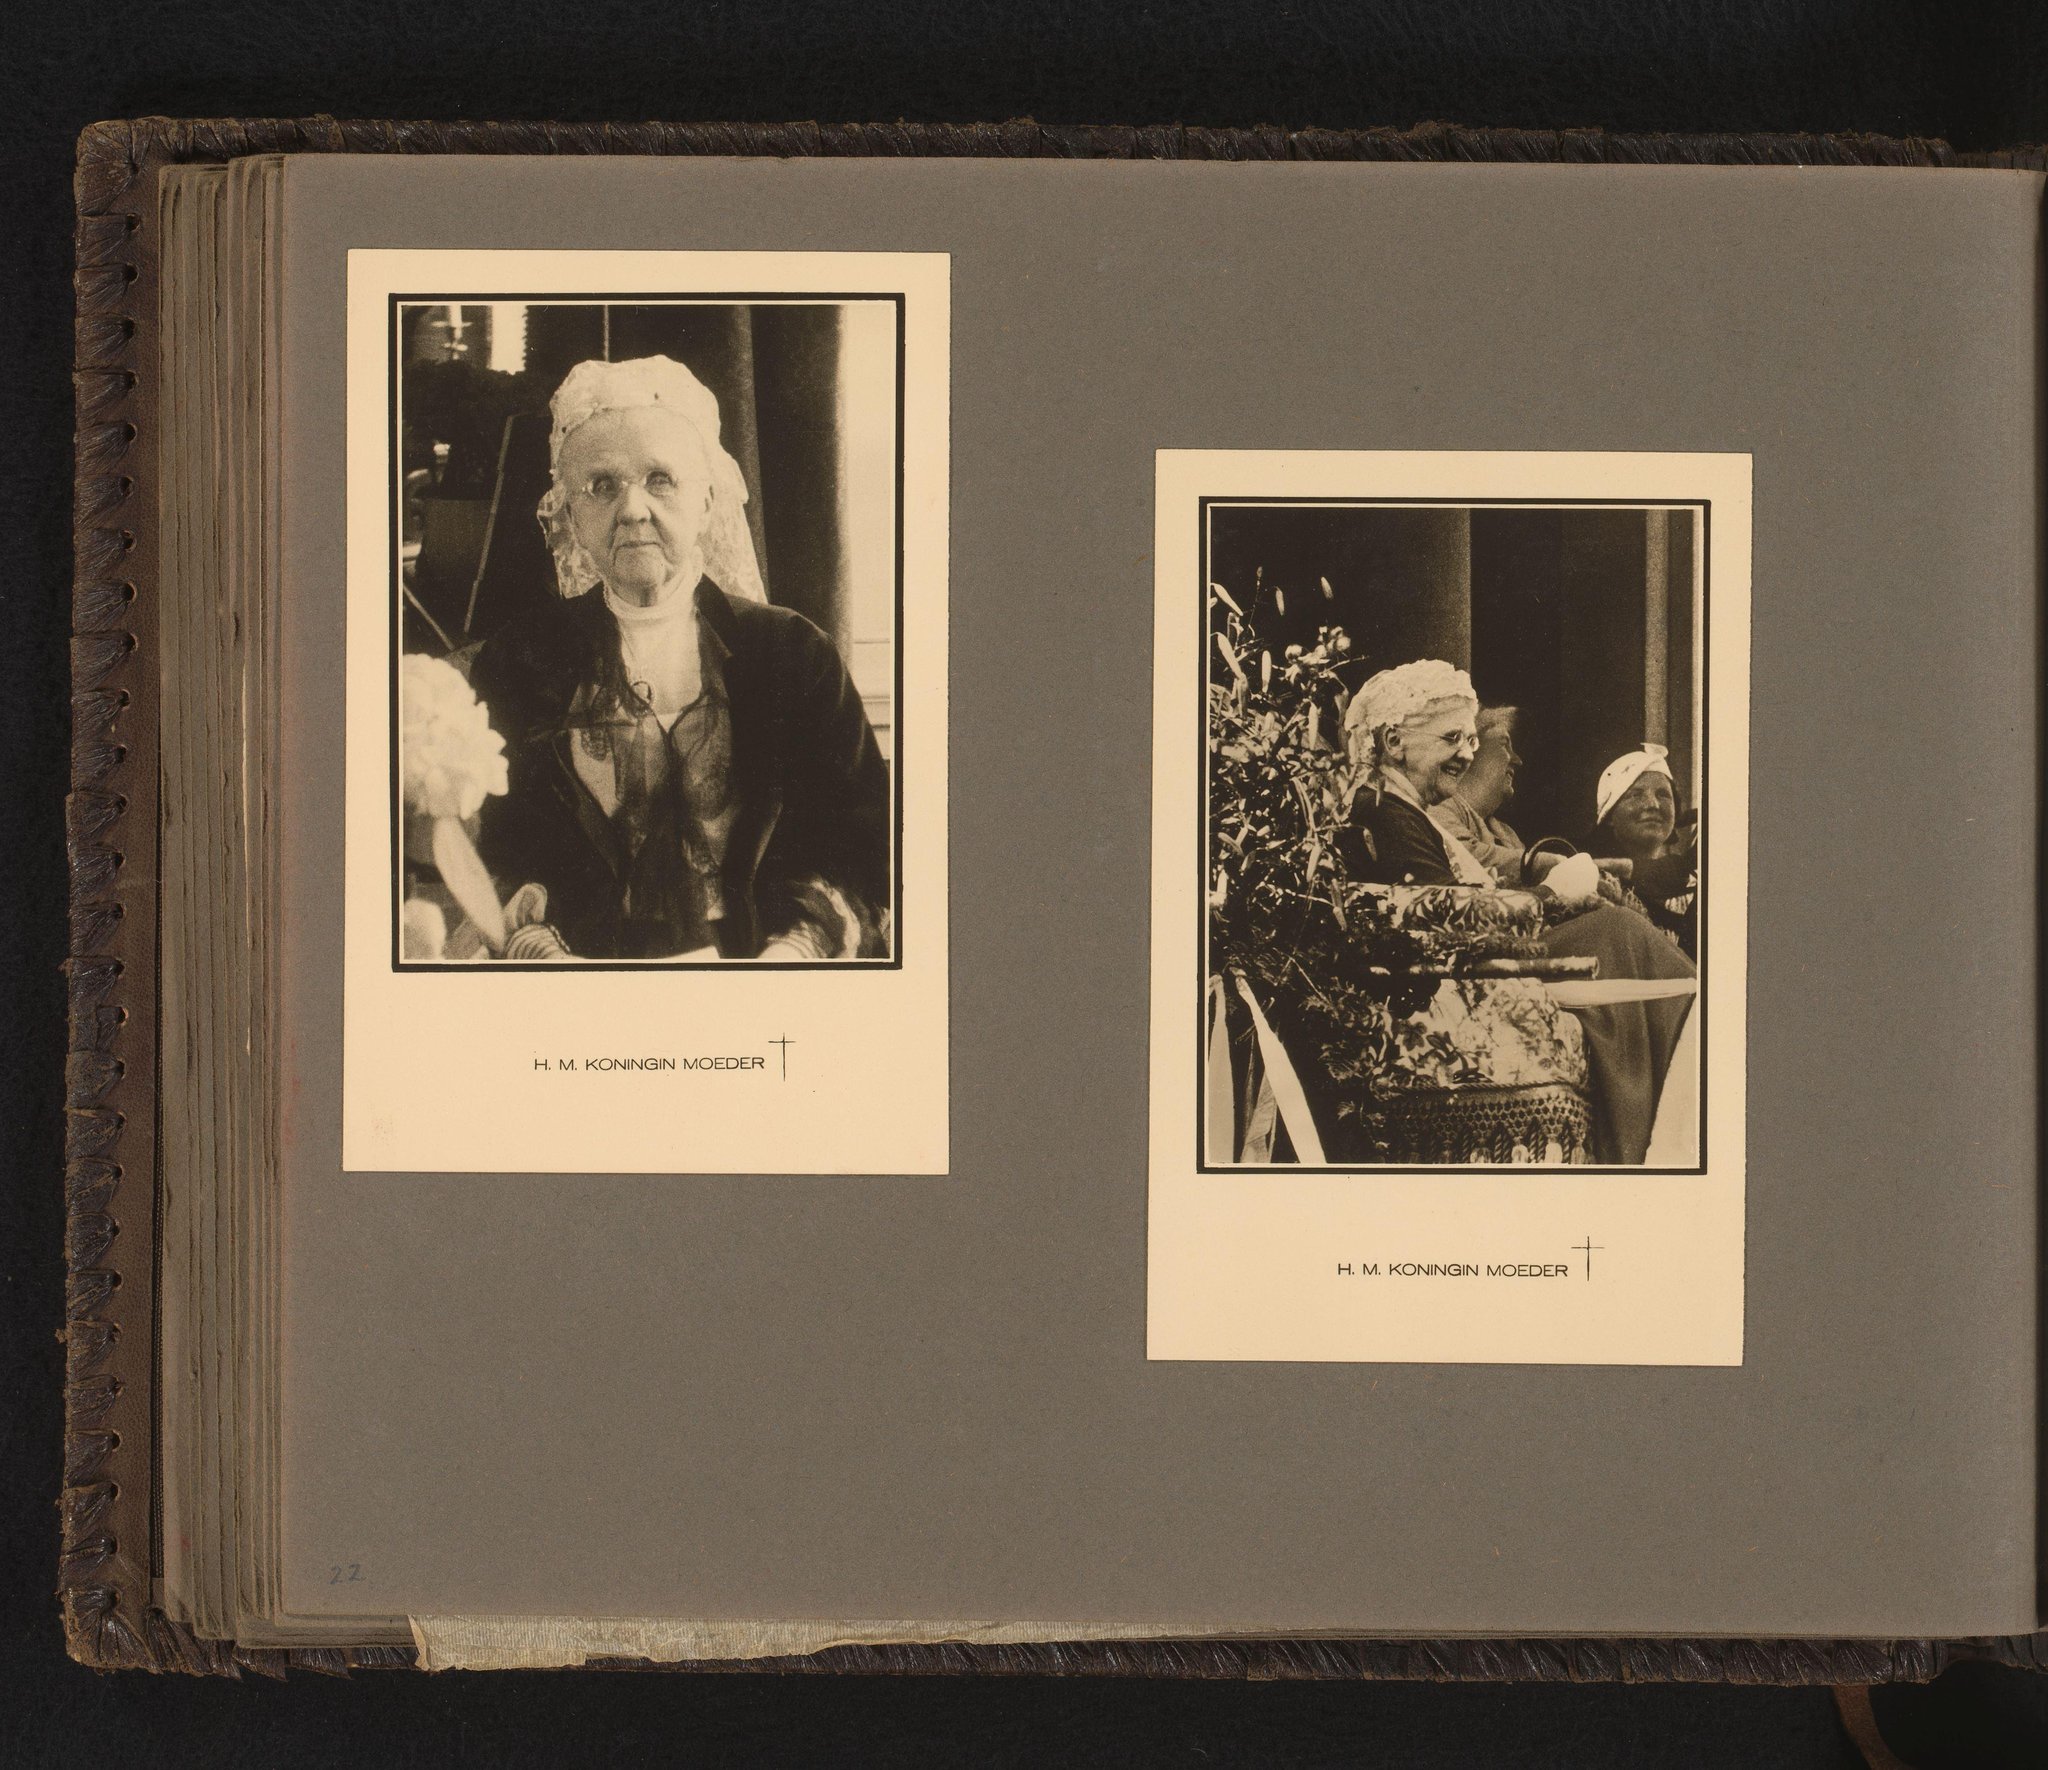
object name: ansichtkaart, prentbriefkaart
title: Twee prentbriefkaarten ter nagedachtenis aan koningin-moeder Emma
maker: Anonymous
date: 1934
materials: paper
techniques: gelatin silver print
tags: the hague, emma (queen consort of the netherlands), old woman, mother of the ruler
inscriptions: inscription: ‘H.M. Koningin Moeder †’, inscription: ‘H.M. Koningin Moeder †’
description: Deze foto's maken deel uit van een album.